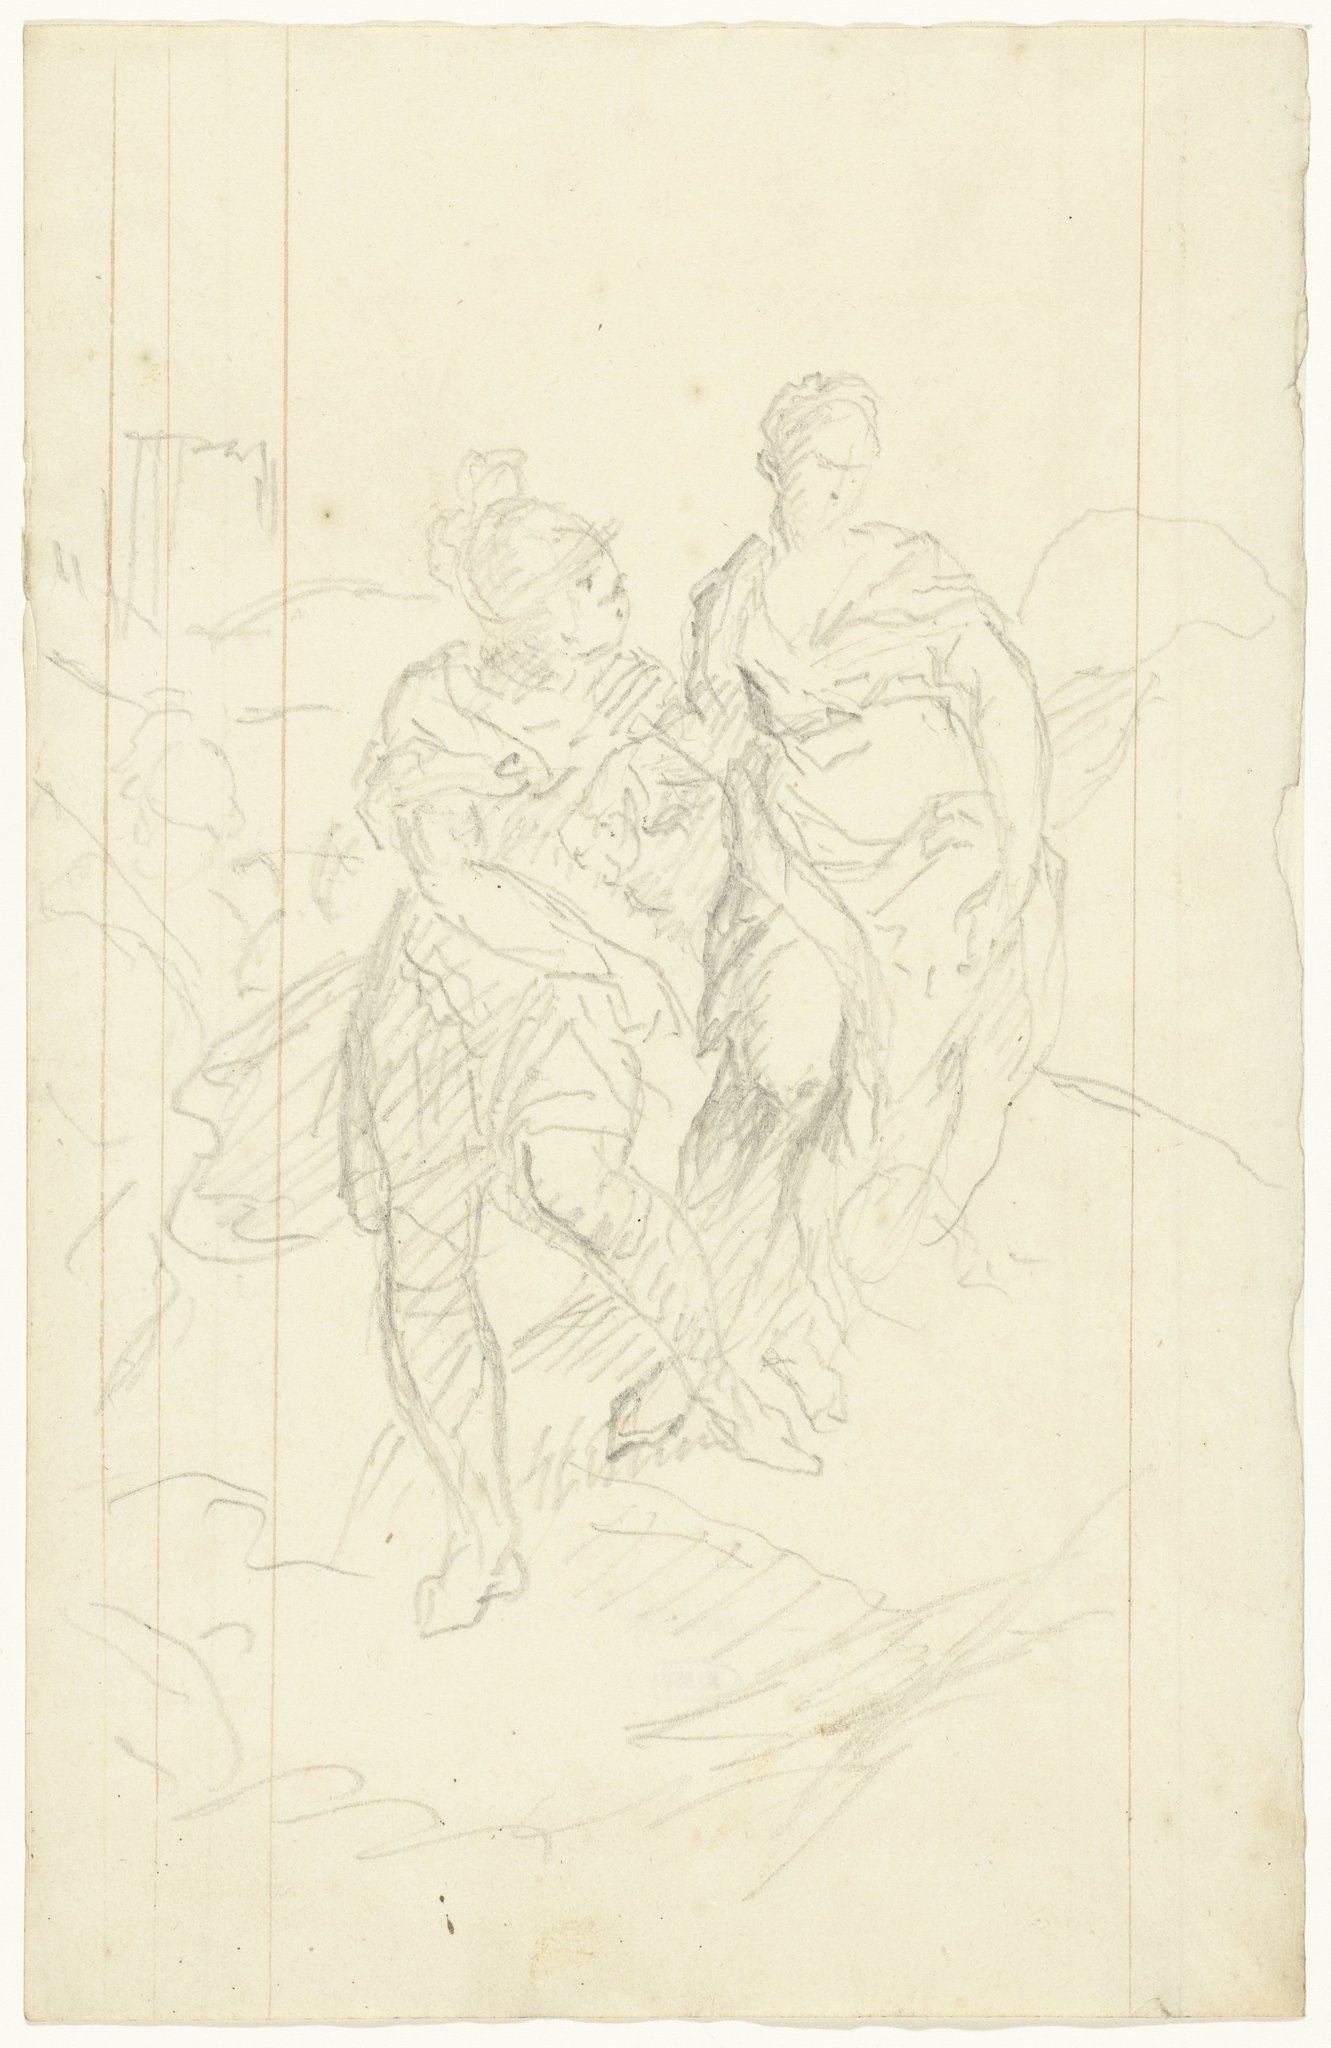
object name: drawing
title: Romeinse krijger die een vrouw meevoert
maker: dionys van nijmegen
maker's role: draughtsman, painter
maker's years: 1705-1798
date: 1715-1798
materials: paper, pencil